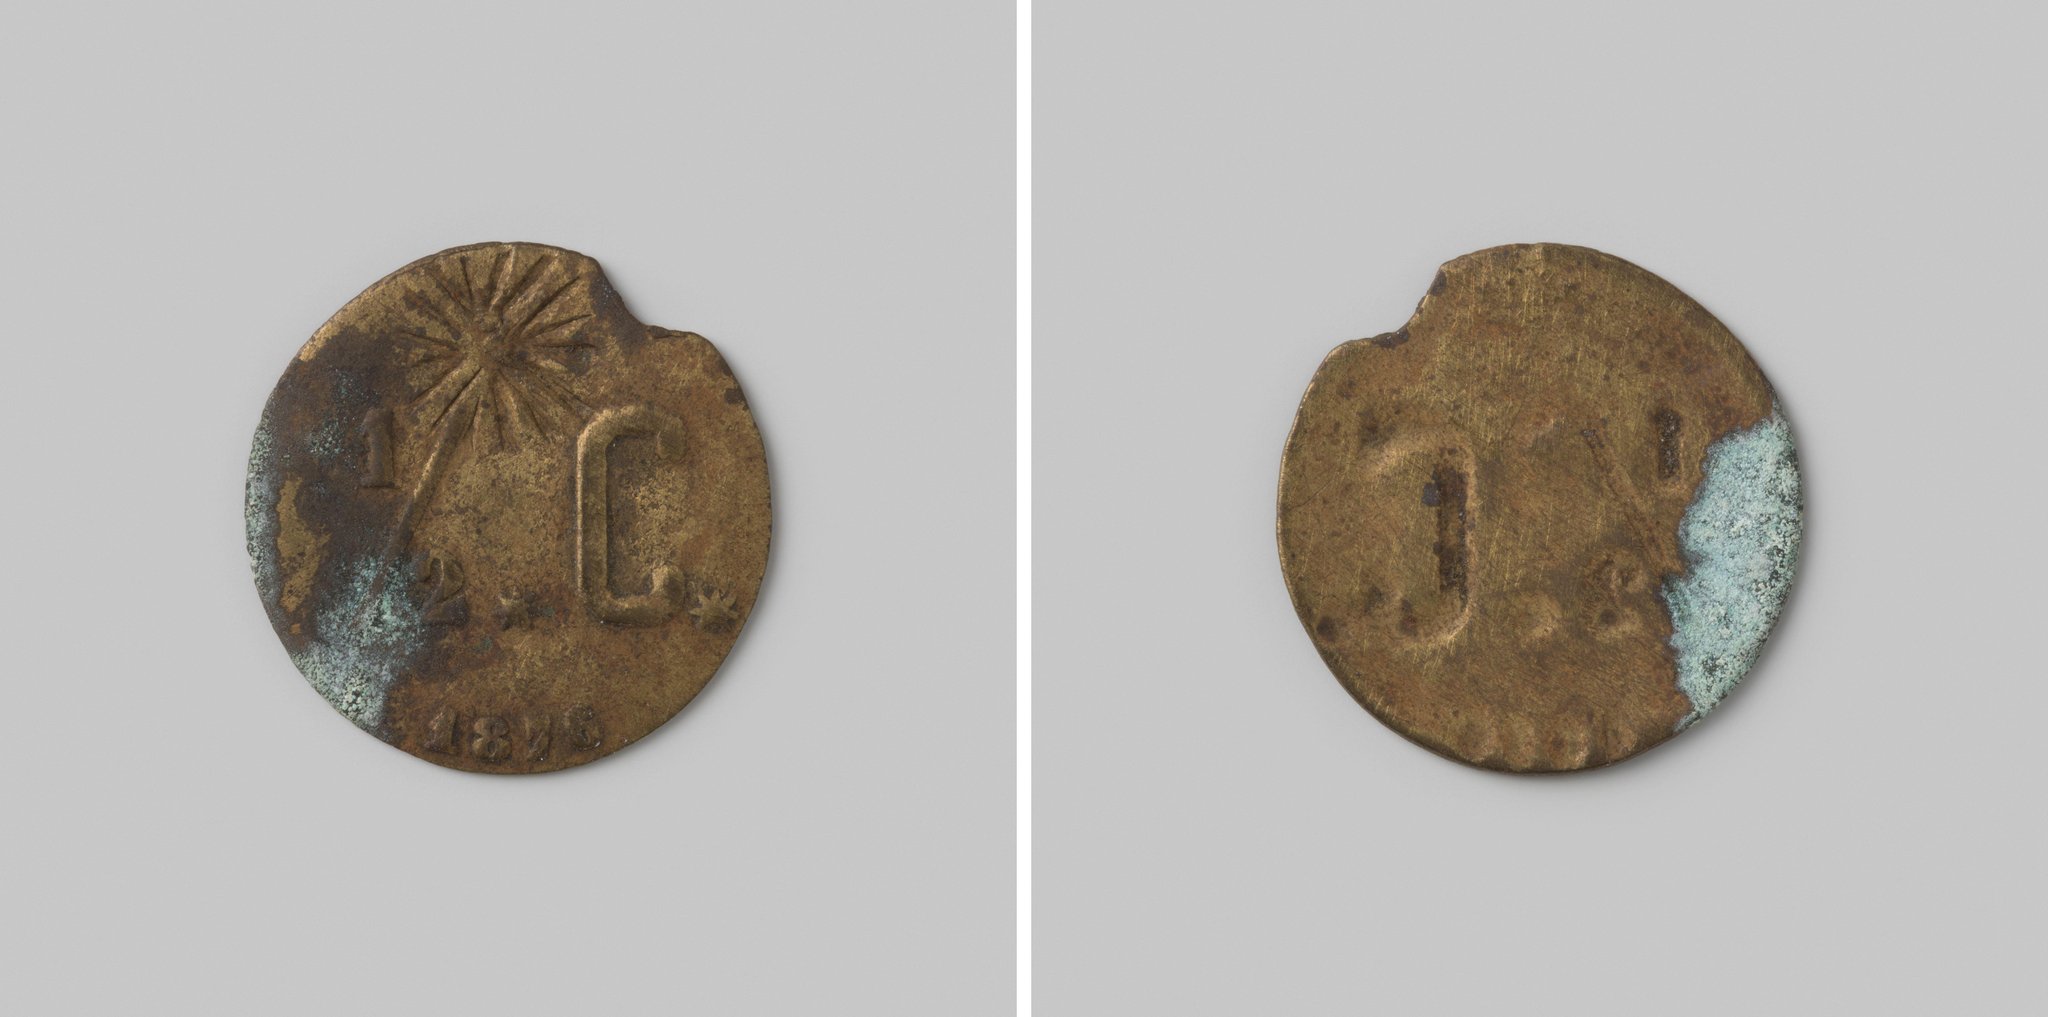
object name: history medal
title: Betaalpenning van ½ cent van de Coöperatieve Winkelvereeniging Eendracht Maakt Magt te Hilversum, 1876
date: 1876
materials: brass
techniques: printing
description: Ronde messing penning met randuitsparing met op de voorzijde de tekst ½*C*, onder 1876, ditzelfde incuus op de keerzijde. Op de voorzijde een ster ingestempeld.